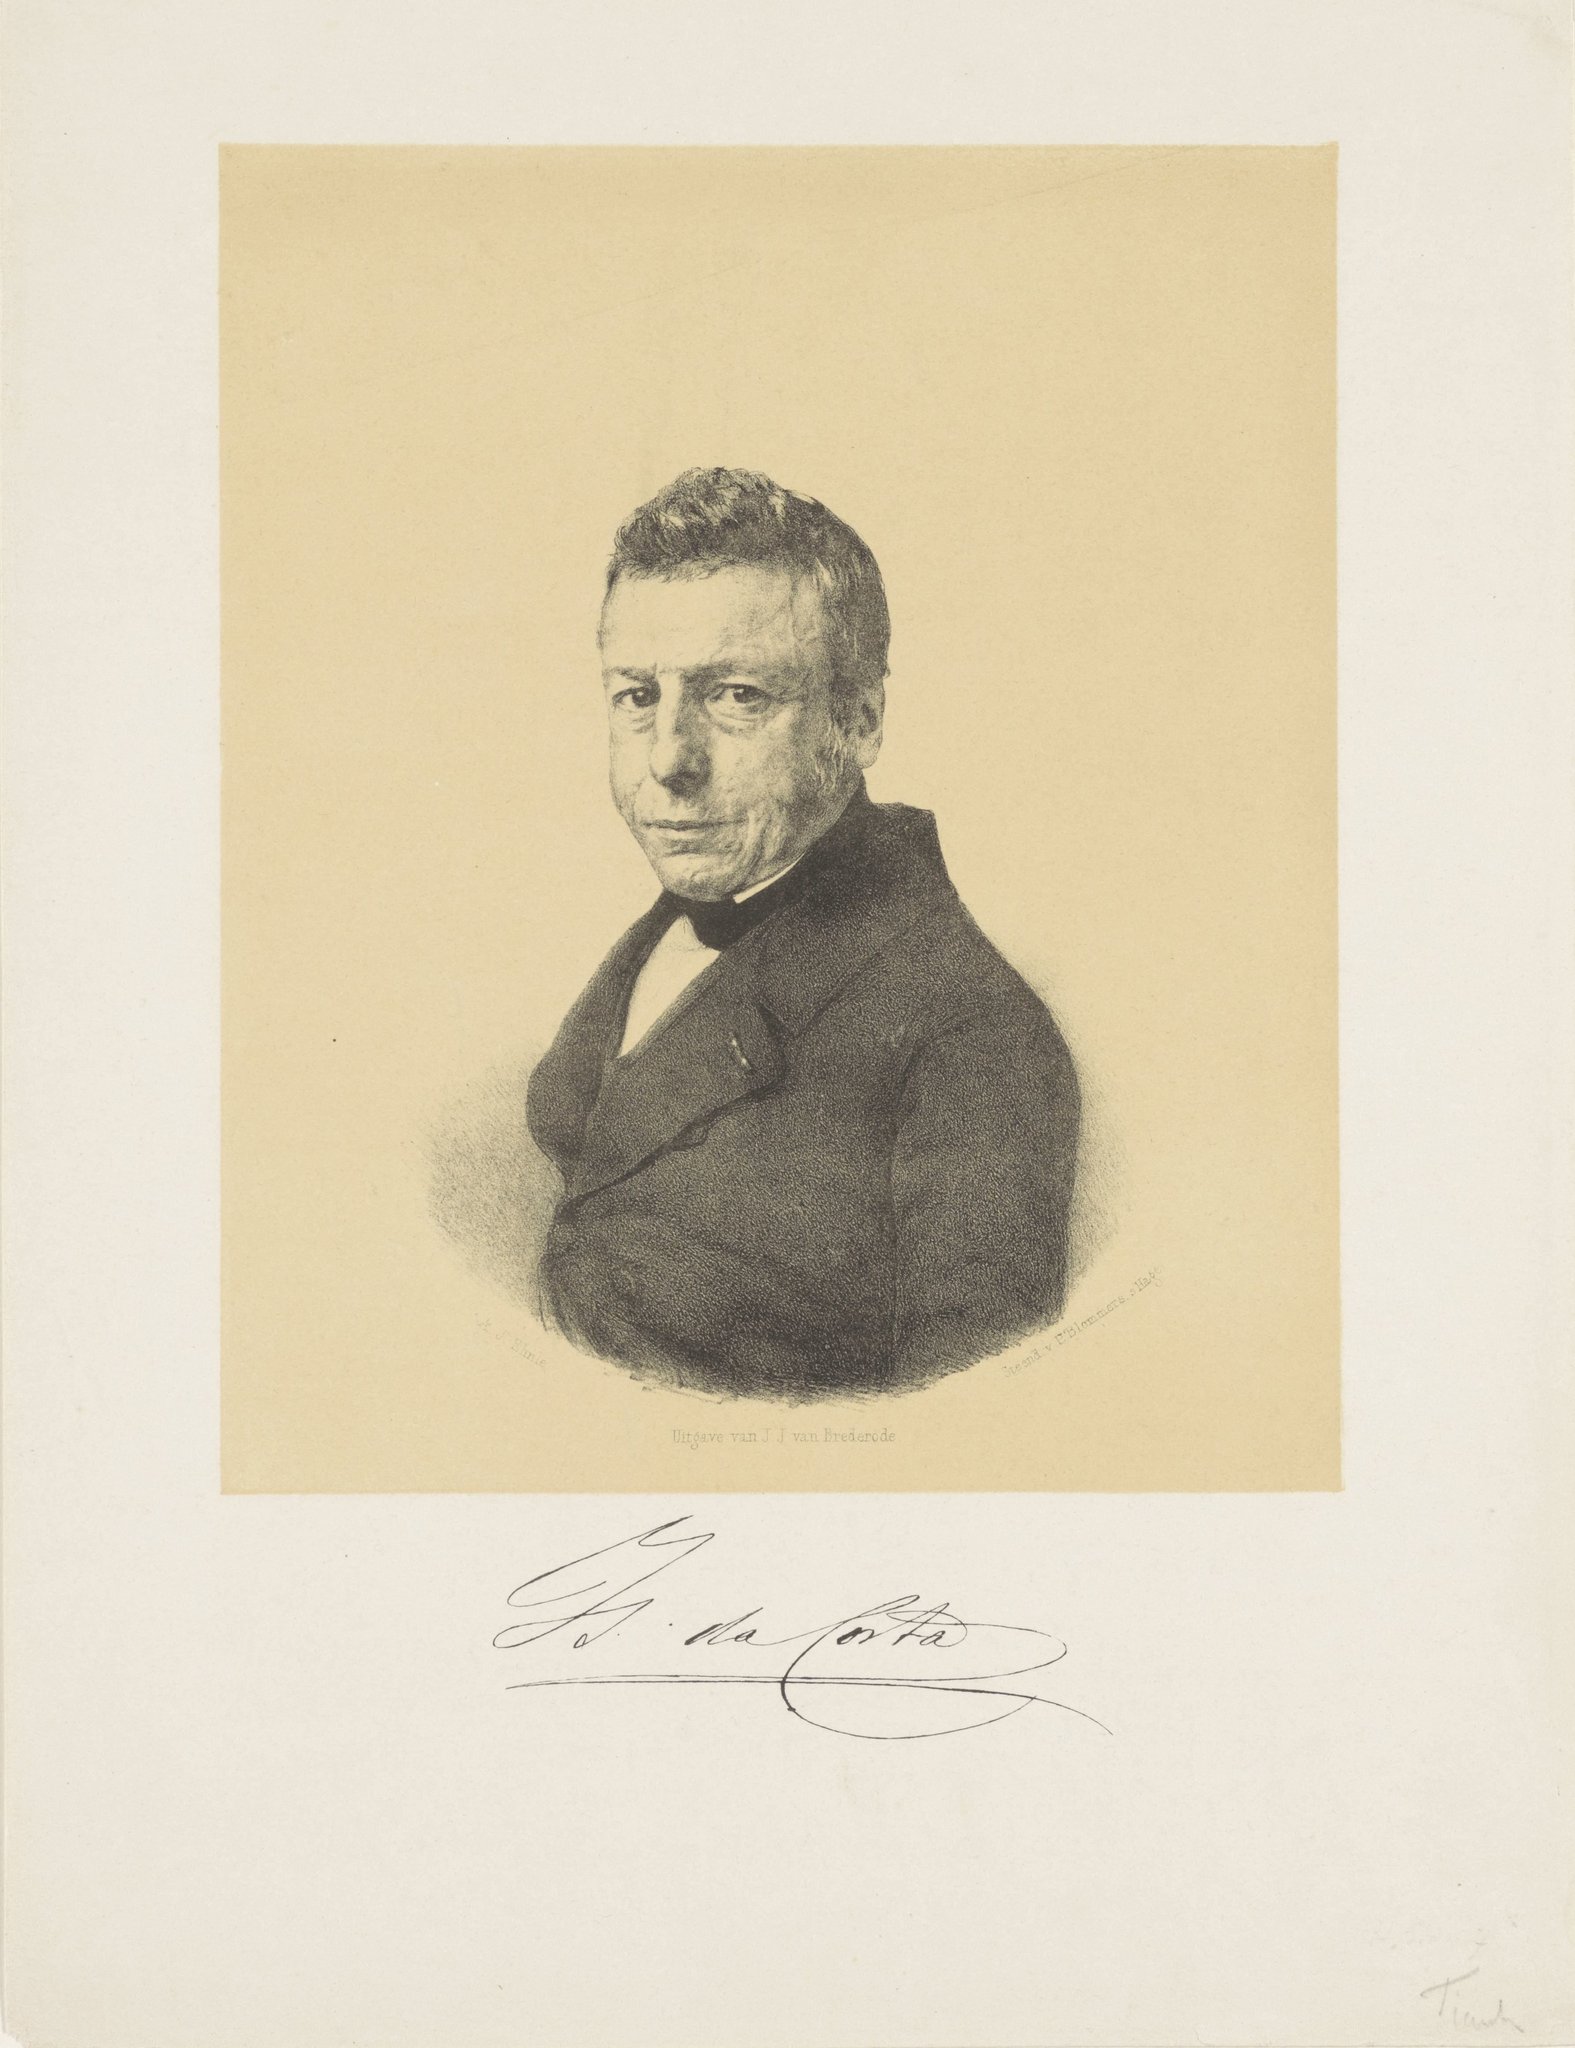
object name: print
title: Portret van Isaac da Costa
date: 1847-1860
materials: paper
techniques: tone lithography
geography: haarlem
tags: knighthood order, historical persons (+ (full) bust portrait)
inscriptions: collector's mark: Lugt 2228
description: De geportretteerde is naar links gewend en draagt een ridderorde op zijn jas. Onder het portret zijn signatuur.